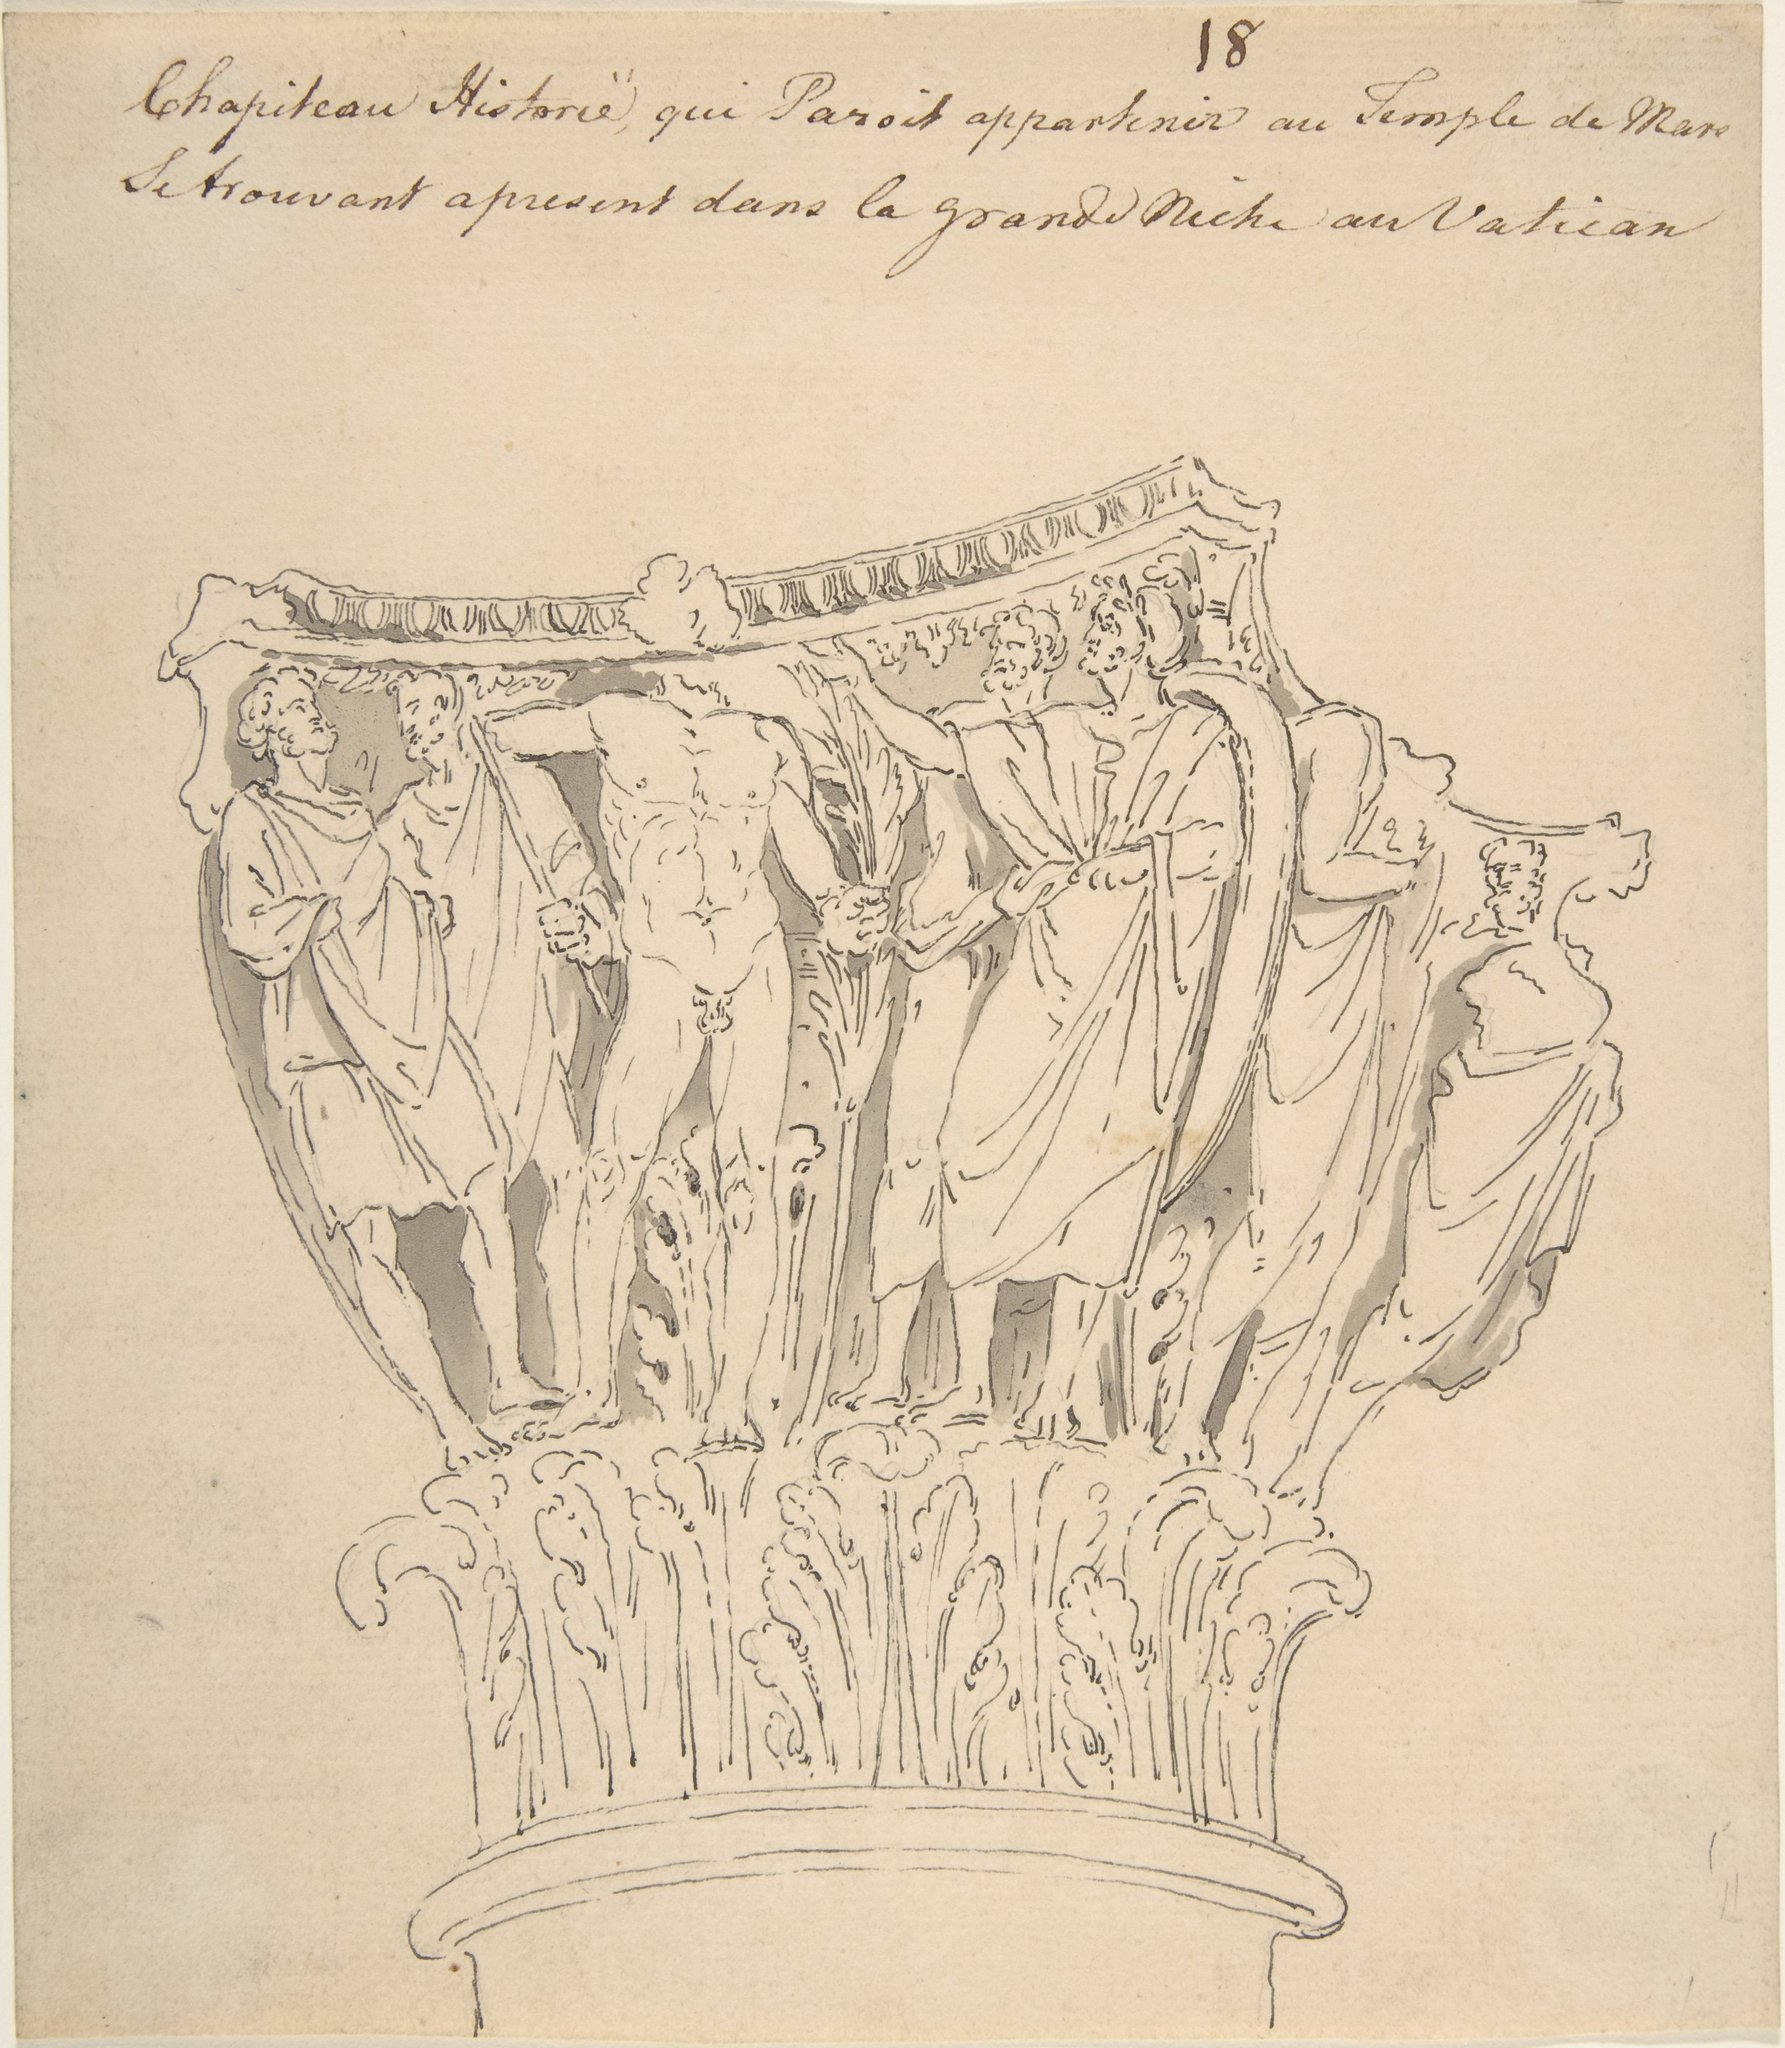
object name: drawing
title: Drawing of Capital from the Vatican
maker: anonymous, french, 18th century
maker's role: artist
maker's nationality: french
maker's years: 1700-1800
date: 1701-1800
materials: ink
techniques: brush, pen, wash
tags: capitals,men,male nudes